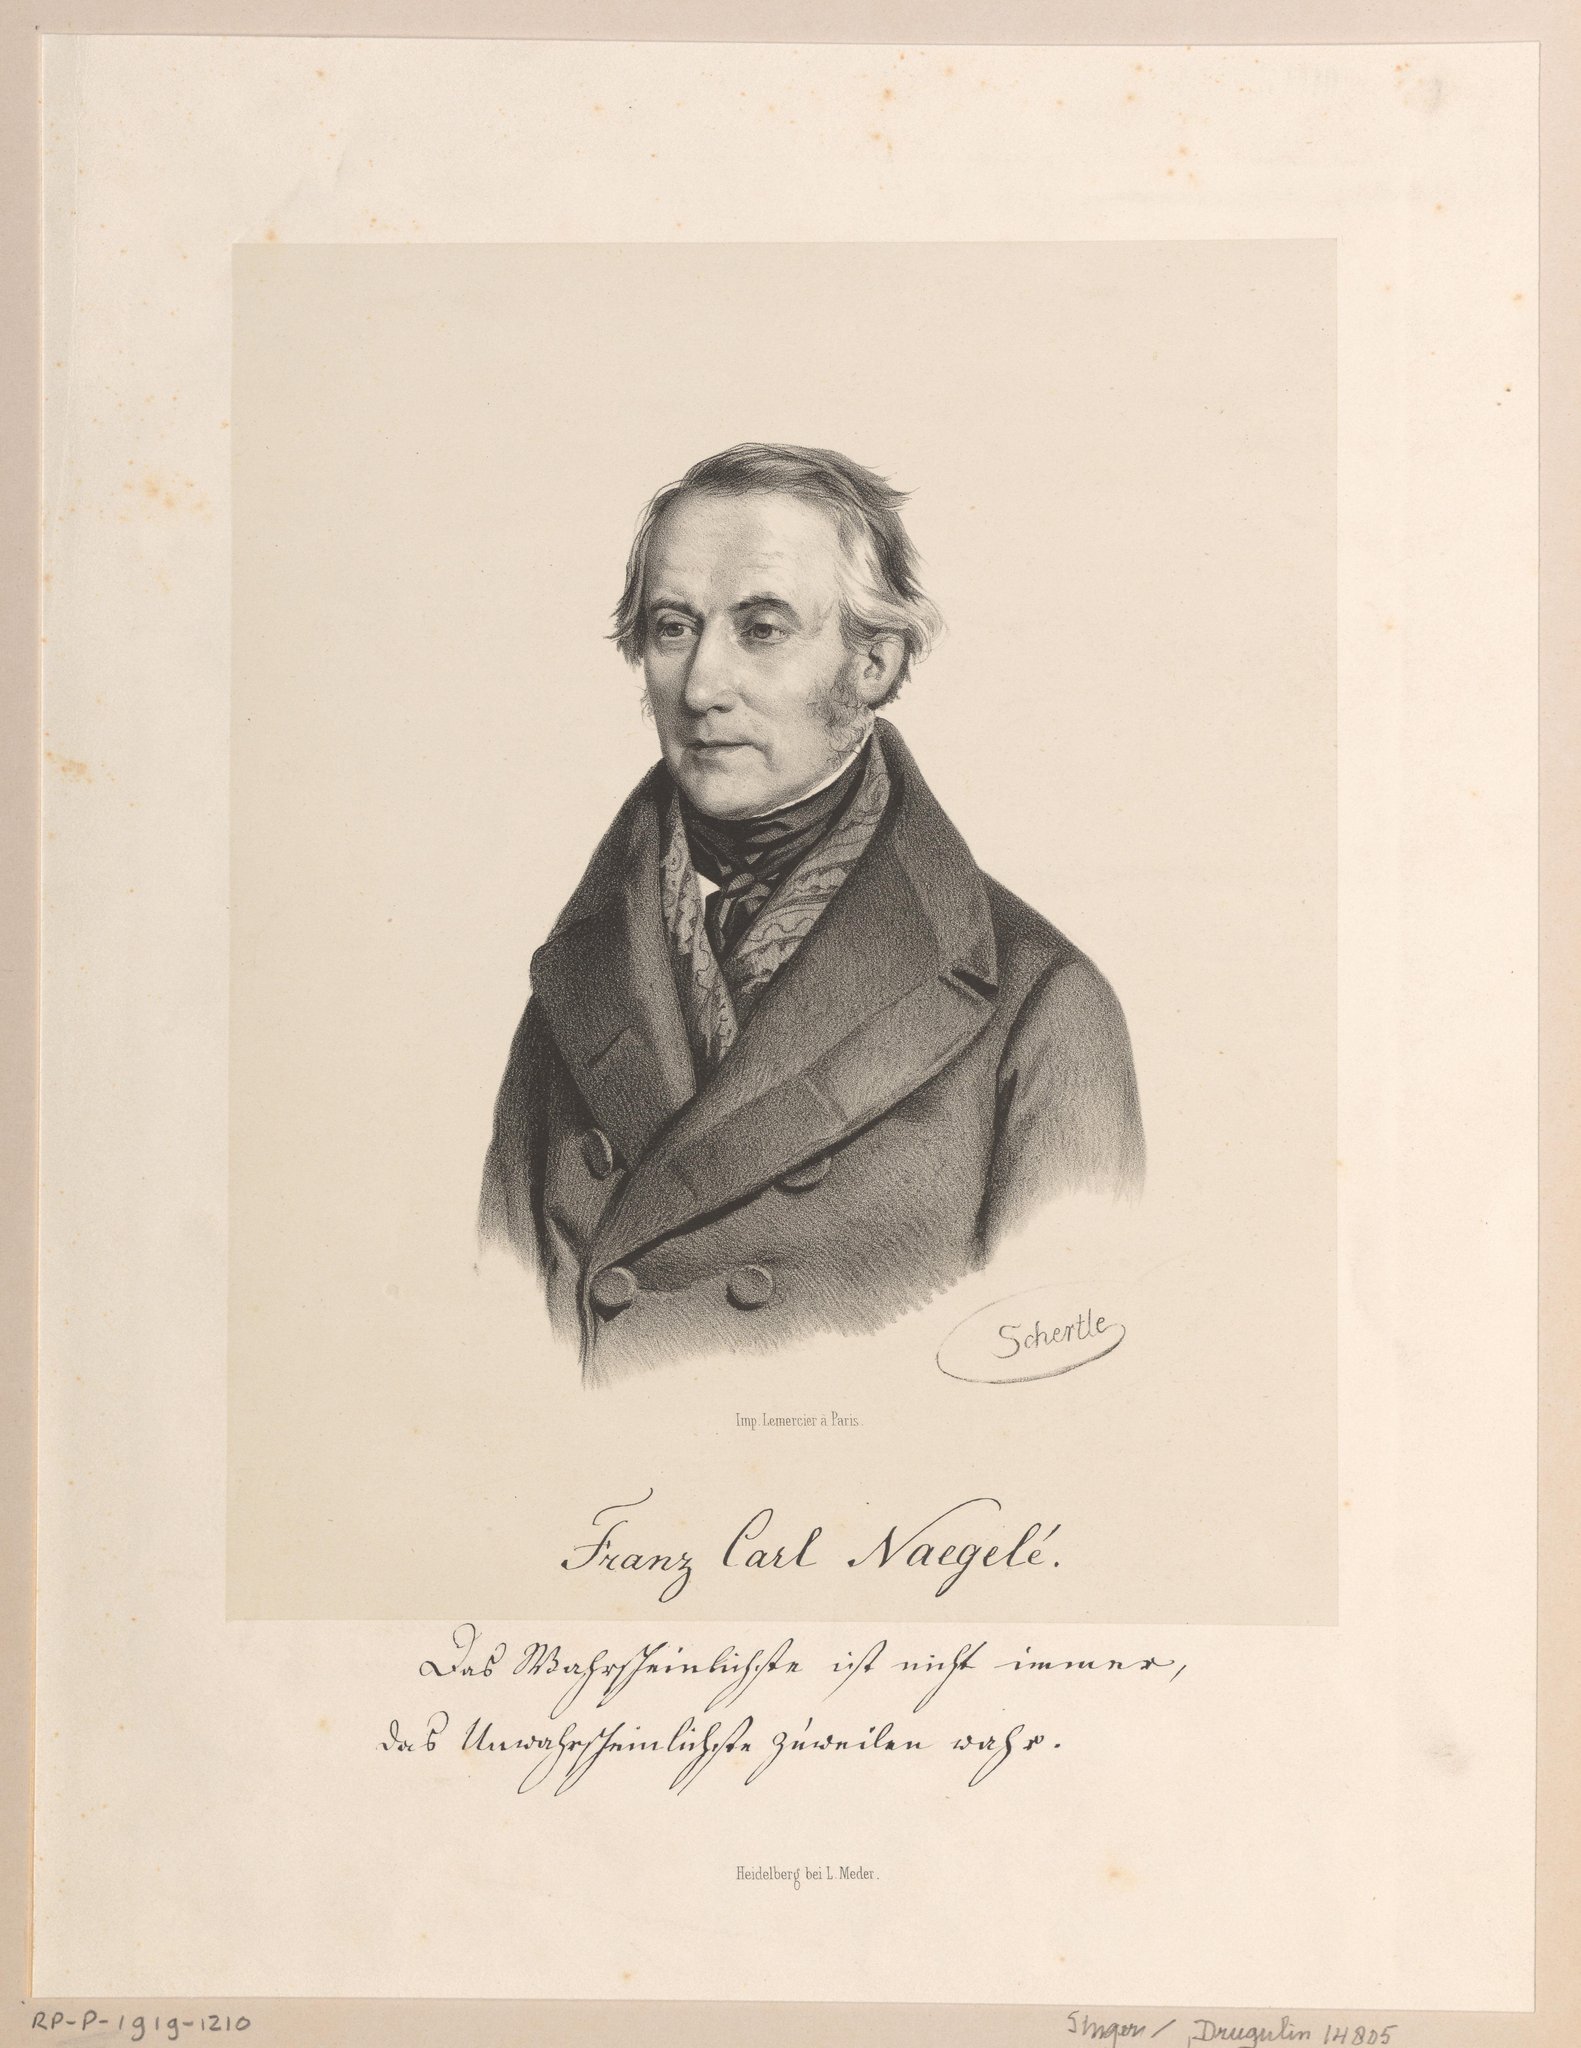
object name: print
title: Portret van Franz Karl Naegele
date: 1850-1879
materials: paper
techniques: lithograph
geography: paris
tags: gynaecology, obstetrics, historical persons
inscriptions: collector's mark: Lugt 2228